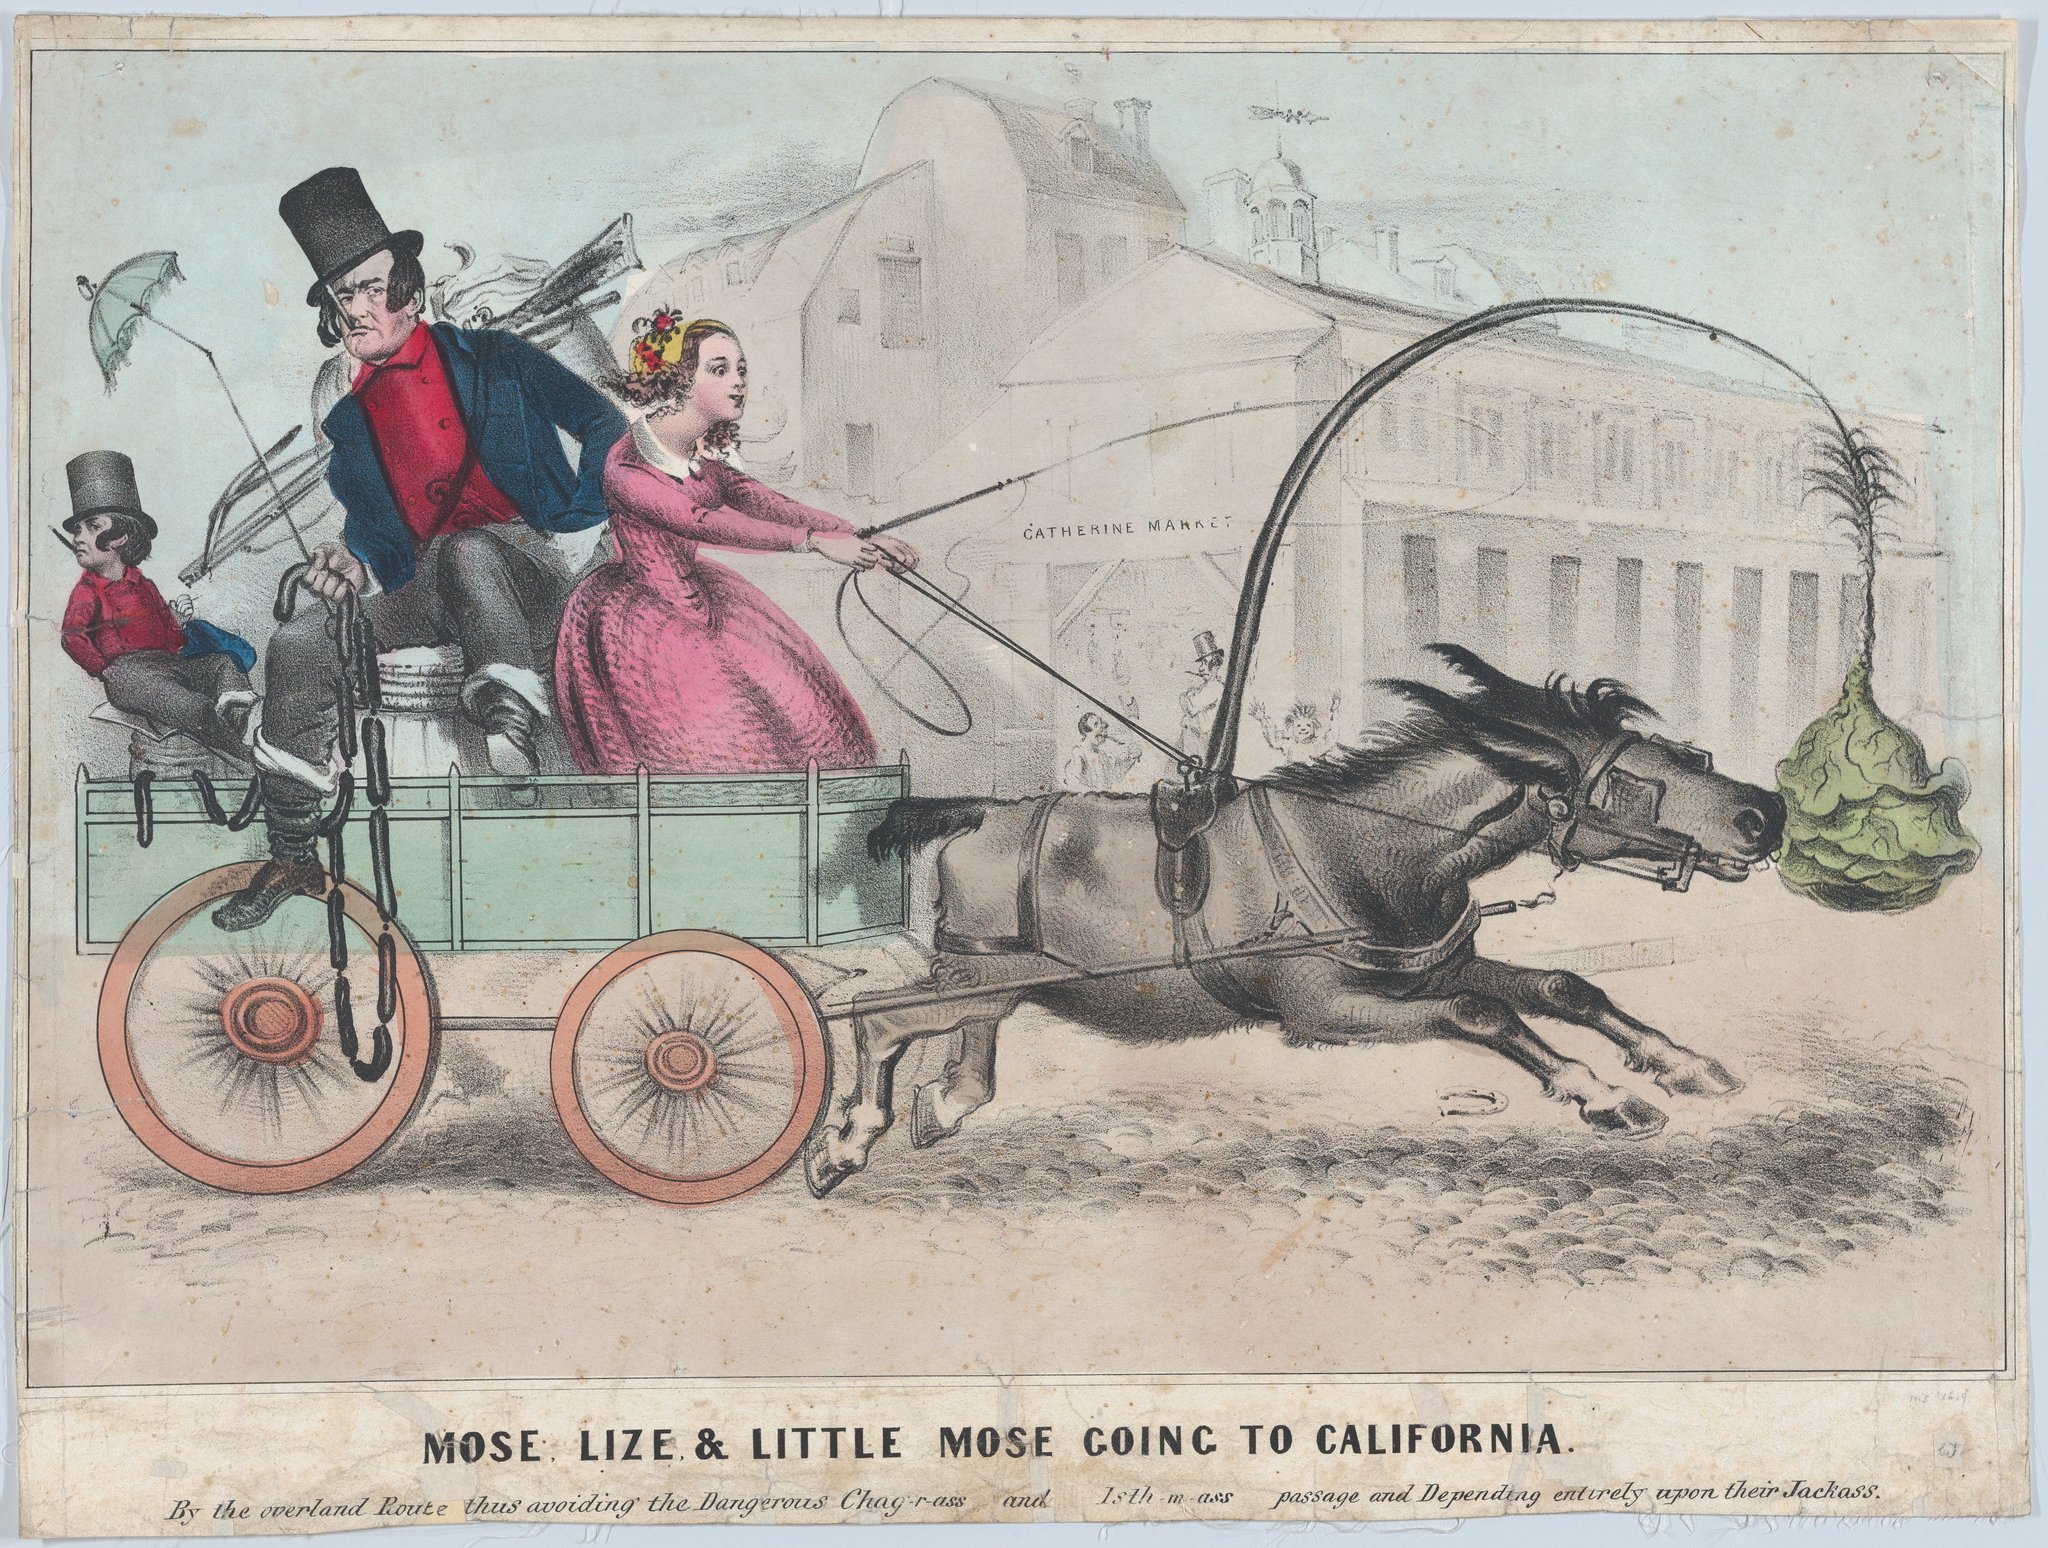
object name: print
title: Mose, Lize & Little Mose Going to California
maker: henry r. robinson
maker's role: artist and publisher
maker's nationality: american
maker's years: 1800-1850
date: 1849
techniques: hand coloring, lithograph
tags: boys,men,women,horses,carriages